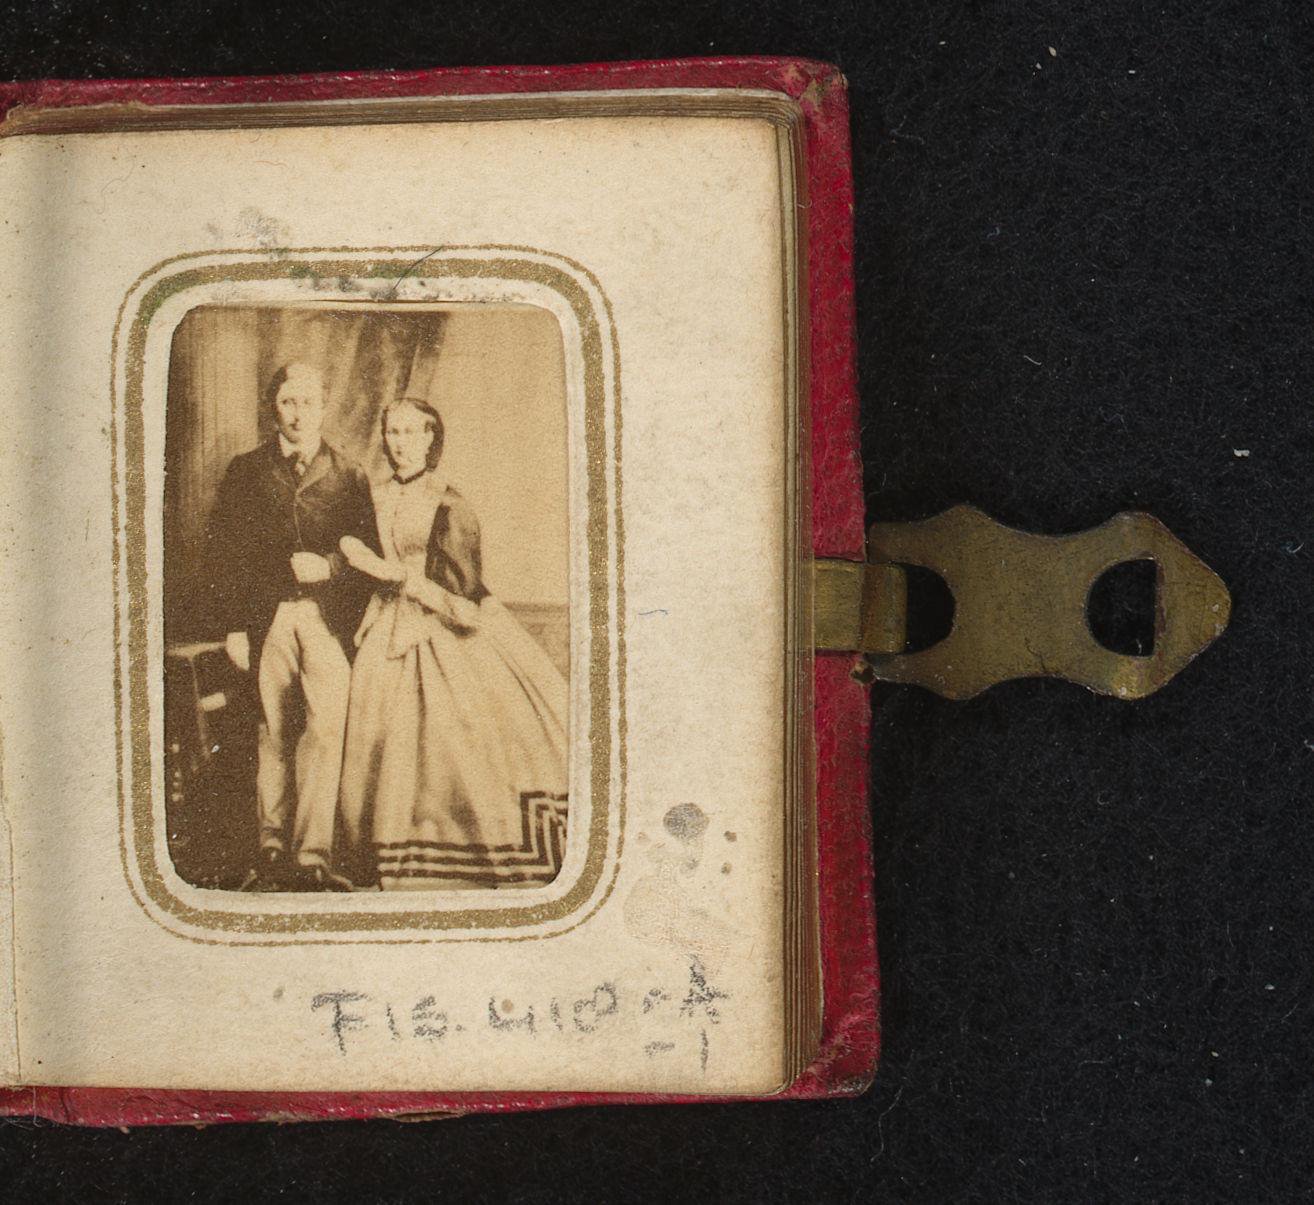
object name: photograph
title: Miniatuurportret van een echtpaar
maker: Anonymous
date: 1851-1900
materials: paper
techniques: albumen print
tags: adult woman, adult man